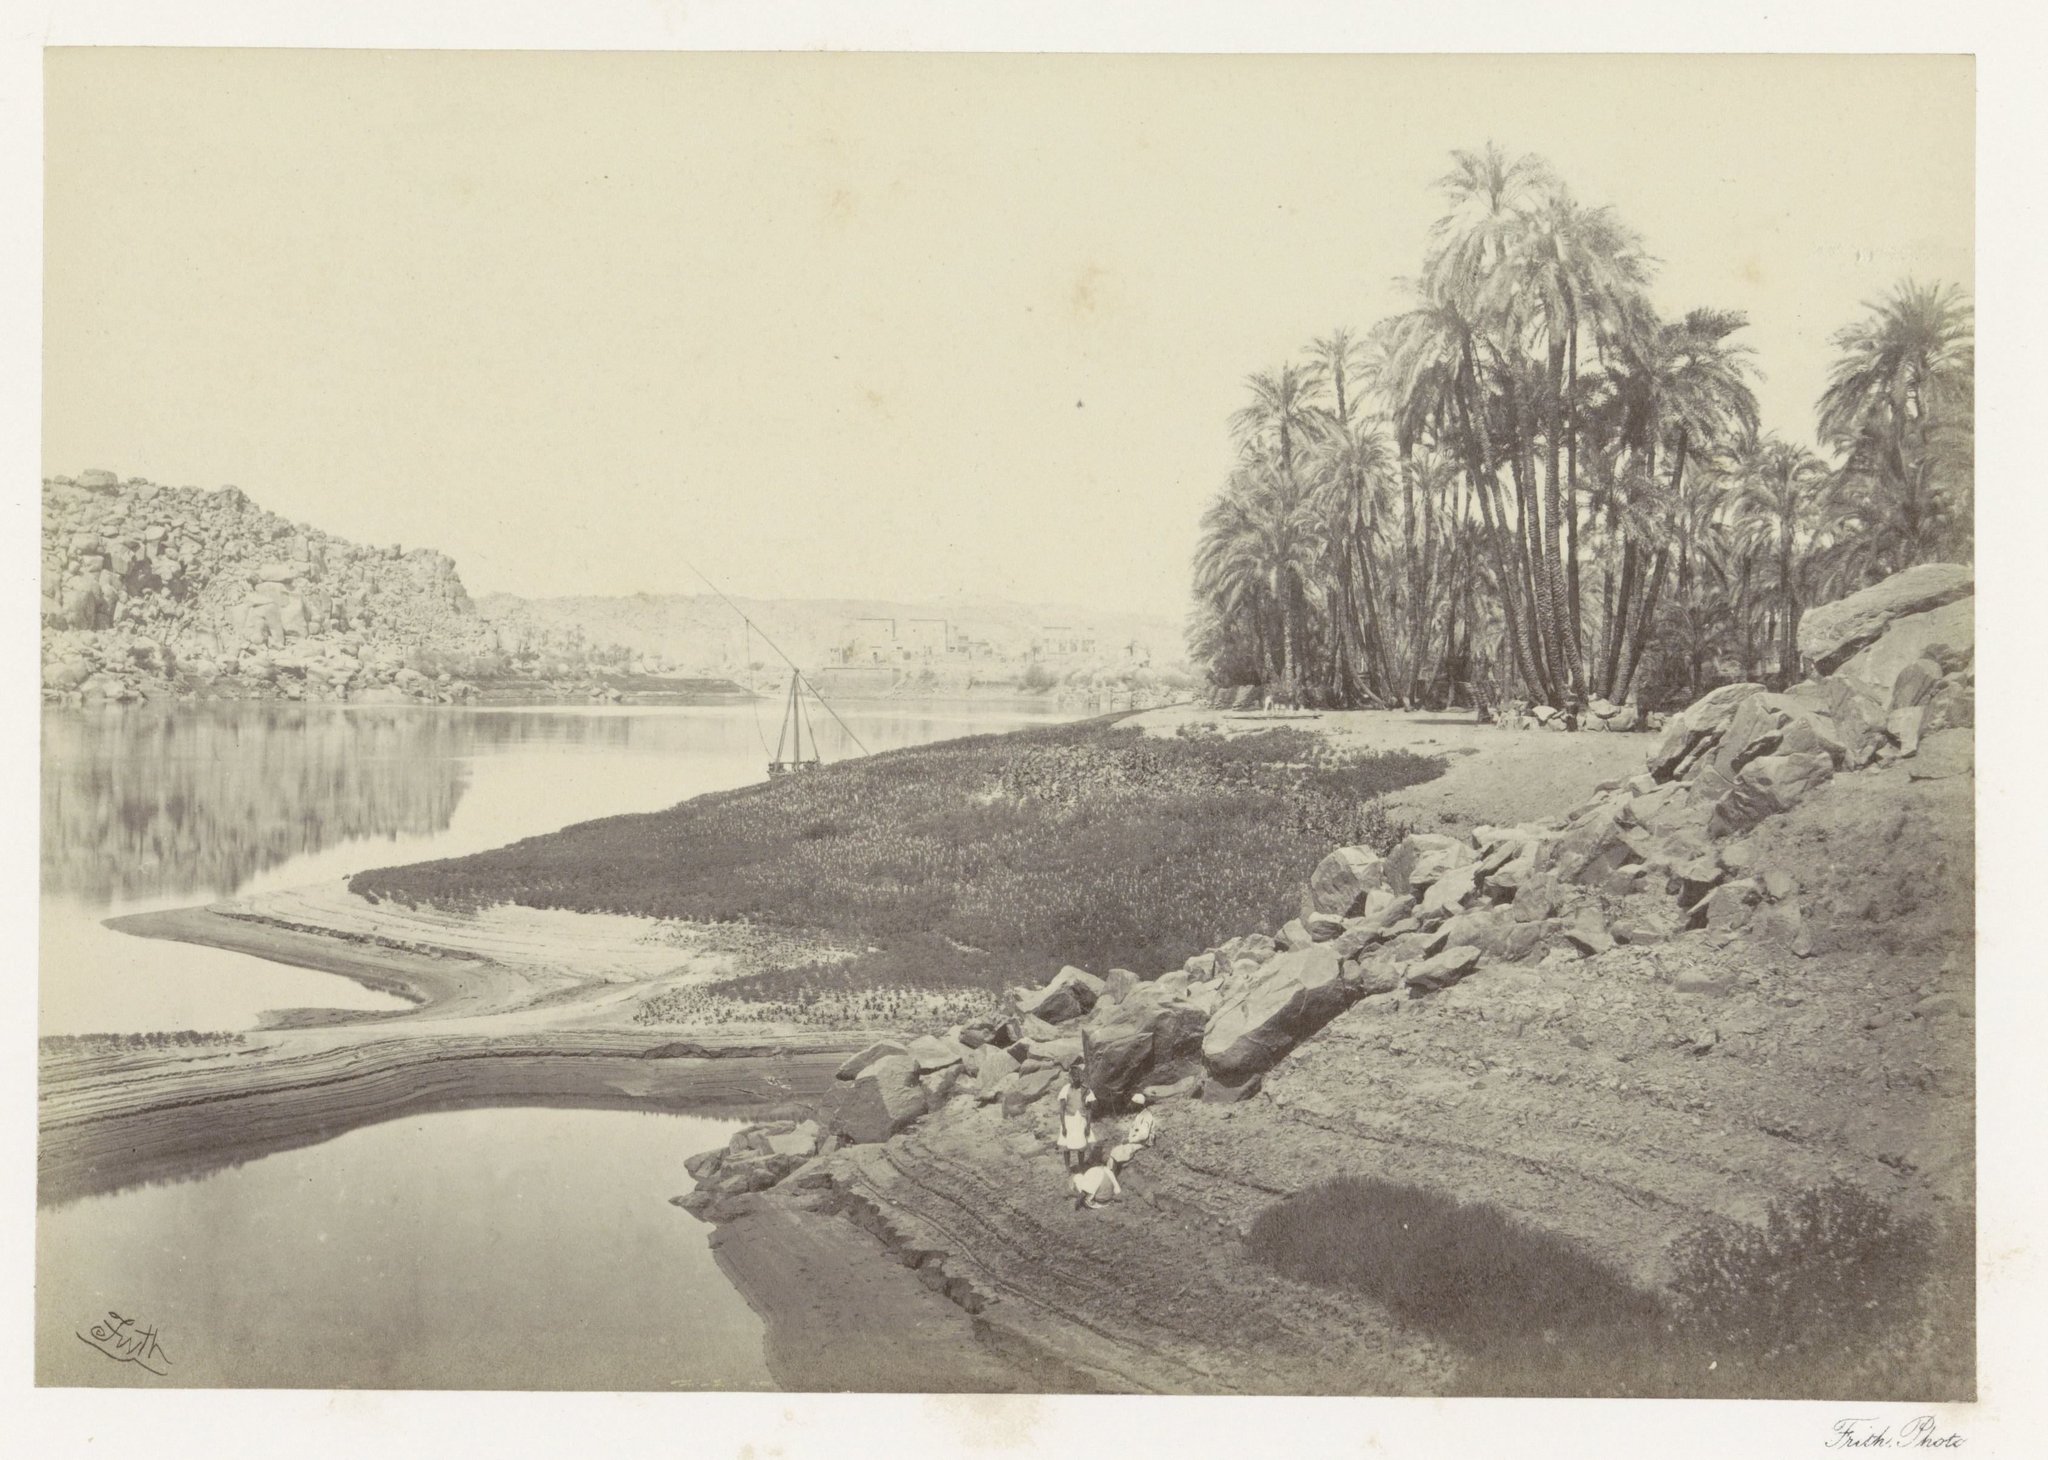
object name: page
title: Philae - from the south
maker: francis frith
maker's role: publisher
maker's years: 1822-1898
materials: paper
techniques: albumen print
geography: philae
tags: island, river, trees: palm-tree